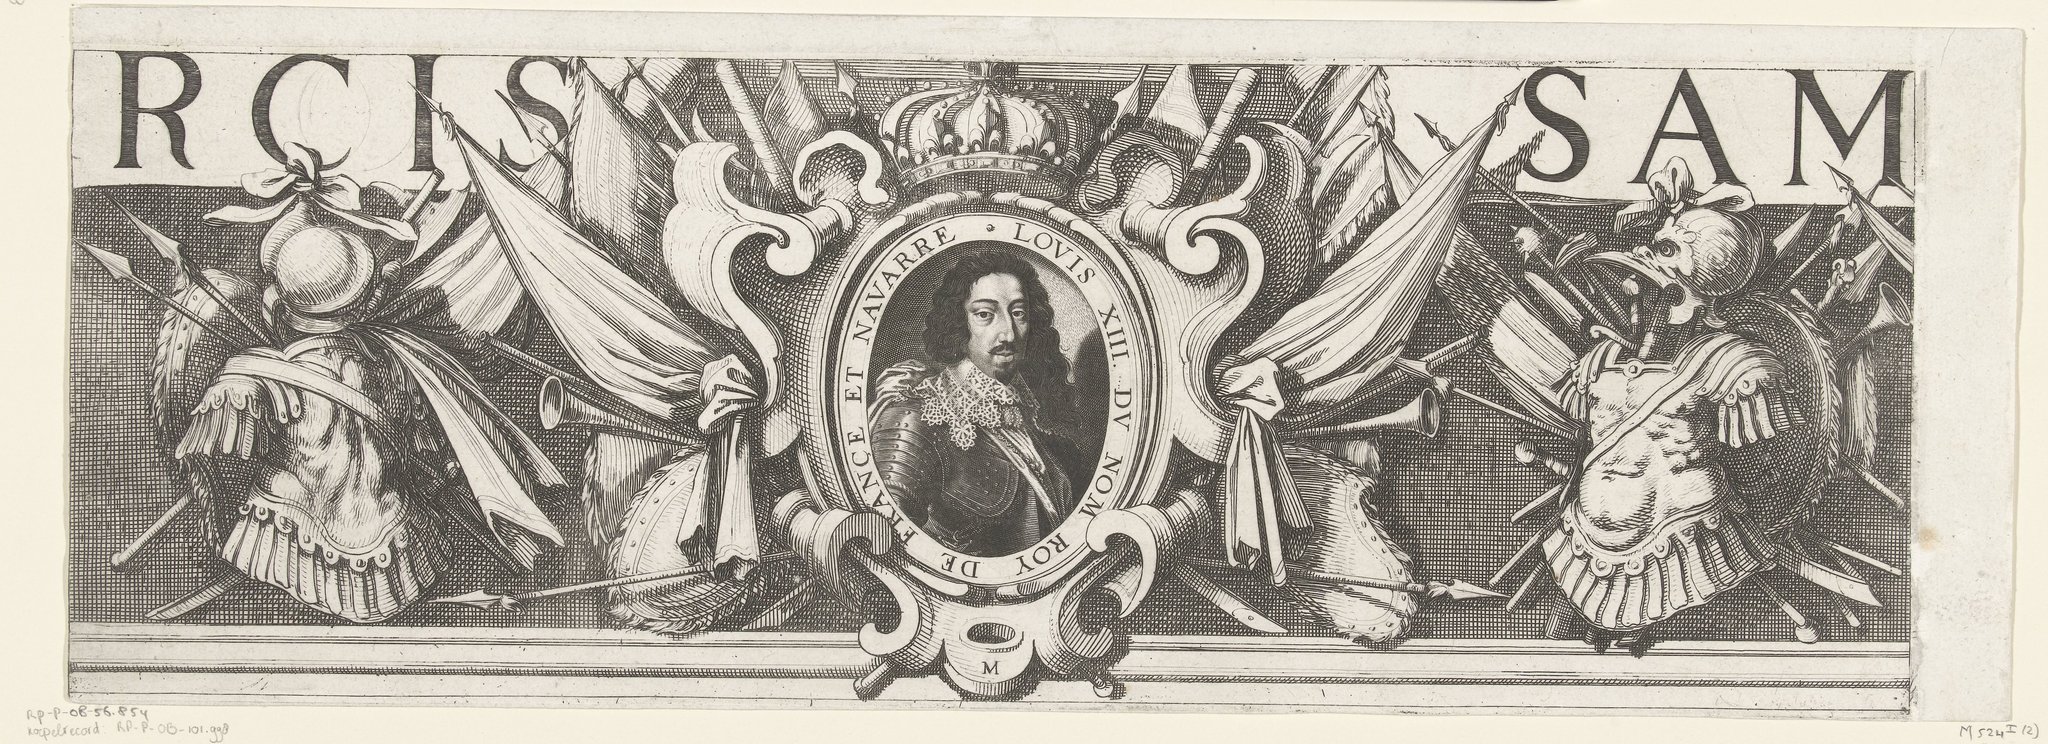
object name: history print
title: Beleg van Saint Martin op het Île de Ré, juli-november 1627 (randwerk, deel middenboven)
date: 1629-1631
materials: paper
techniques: engraving, etching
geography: paris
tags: lodewijk xiii (koning van frankrijk), historical persons, ornament ~ cartouche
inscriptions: collector's mark: Lugt 240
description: Zestiende deel (randwerk, deel middenboven) van een prent van het beleg van de citadel Saint Martin op het Île de Ré in 1627, dat werd uitgevoerd door Engelse troepen onder leiding van de hertog van Buckingham en werd beëindigd door Franse troepen onder leiding van kardinaal Richelieu. Op dit blad een portret van Lodewijk XIII in ovaal met randschrift, omgeven door een kroon en militaire attributen. Linksboven de letters 'RCIS' en rechtsboven de letters 'SAM', delen van het opschrift van de prent.